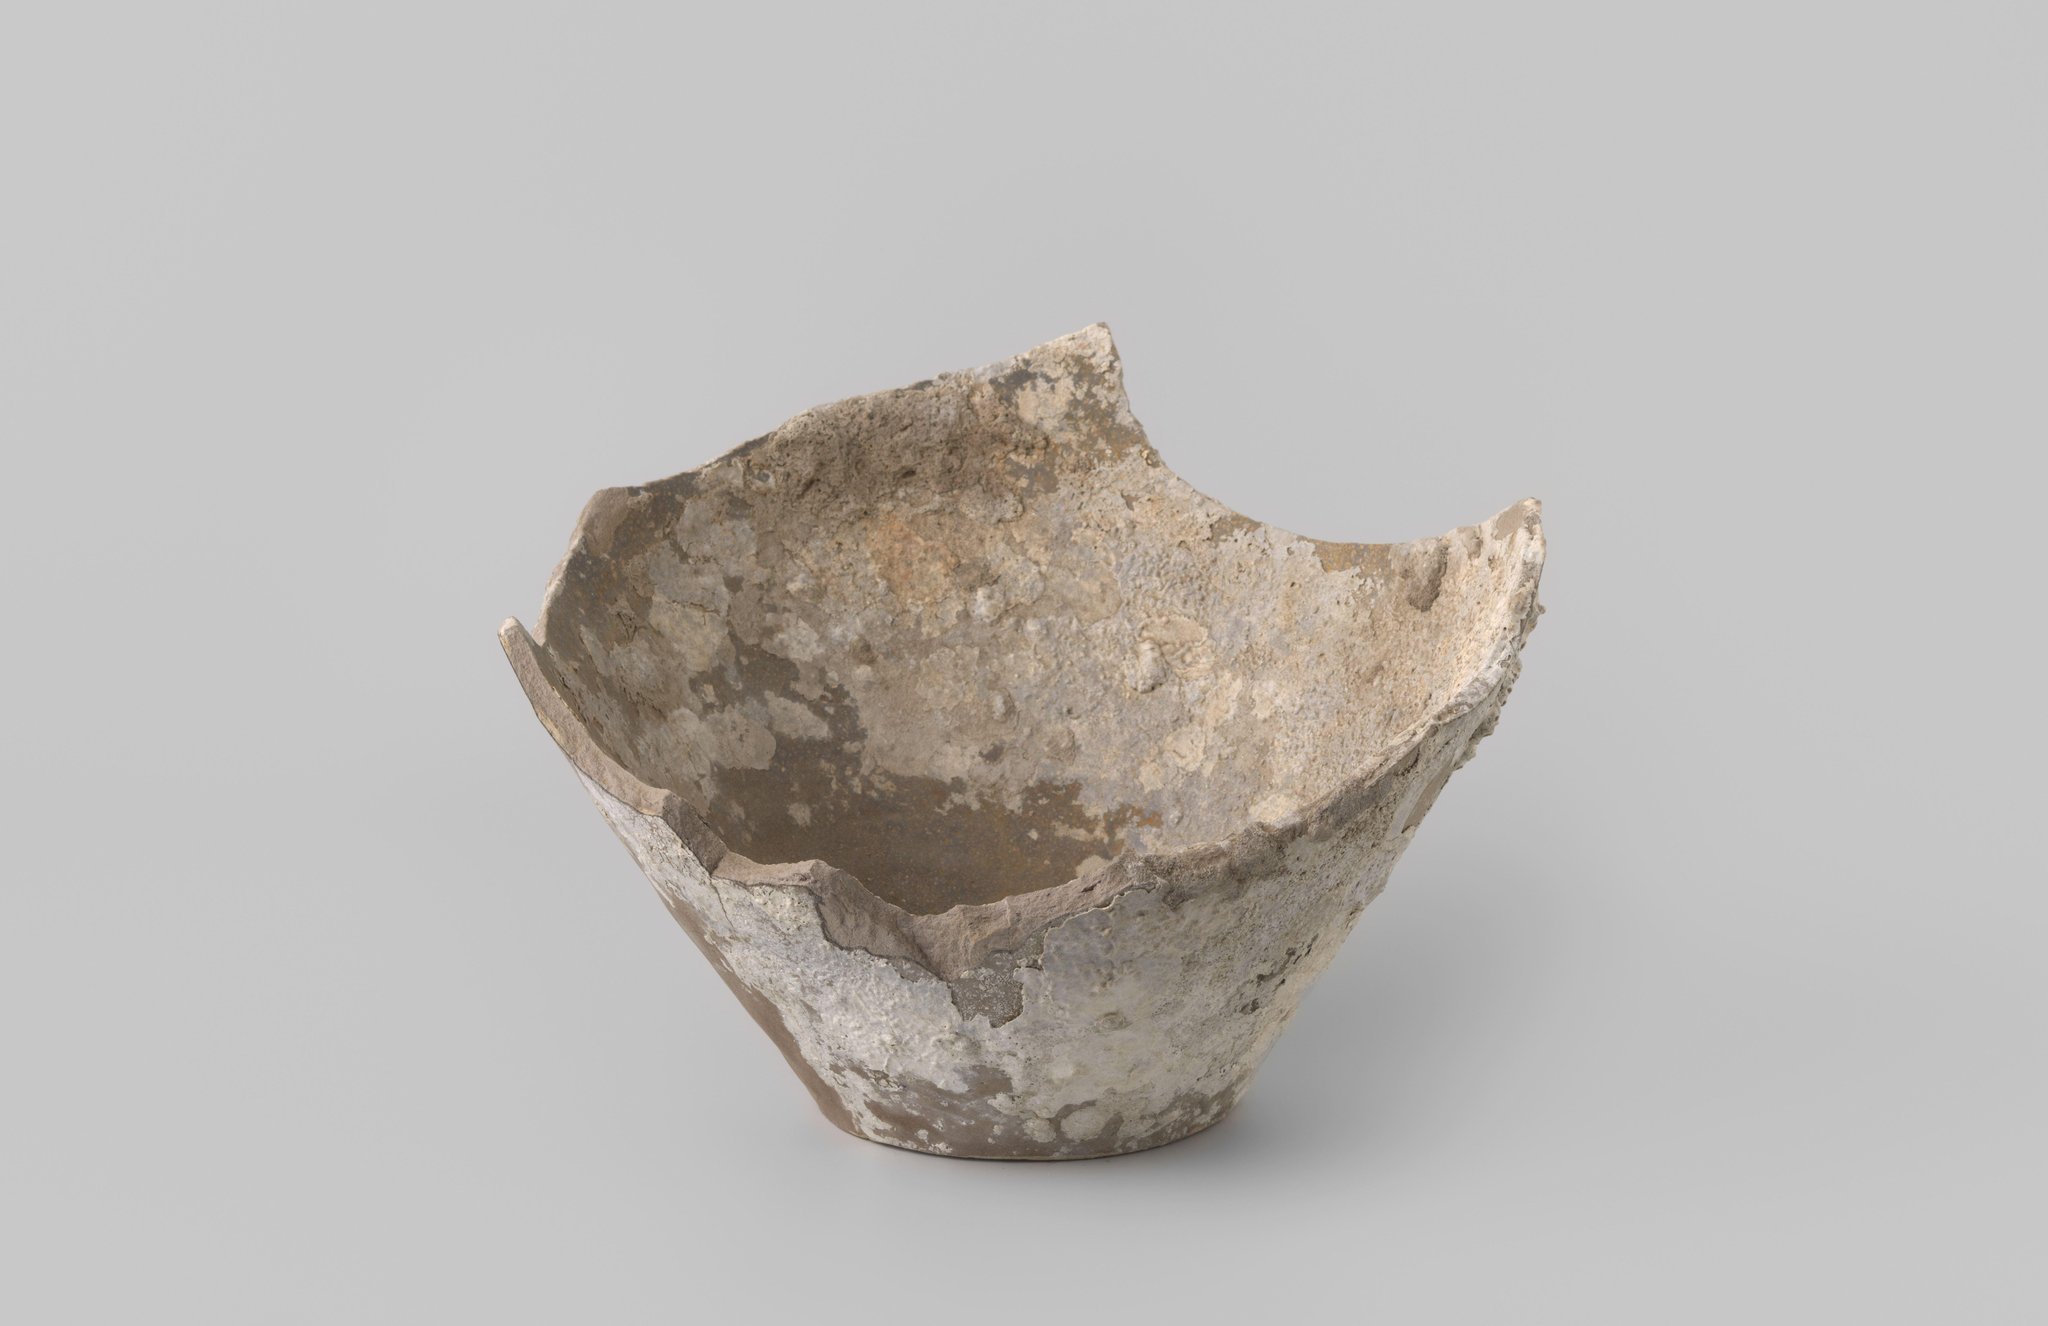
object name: sherd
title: Bodem van een martavaan uit V.O.C.-schip de 'Witte Leeuw'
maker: Anonymous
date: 1613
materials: porcelain, stoneware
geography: southeast asia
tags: verenigde oostindische compagnie, sint-helena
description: Bodem van een martavaan uit V.O.C.-schip de 'Witte Leeuw'.